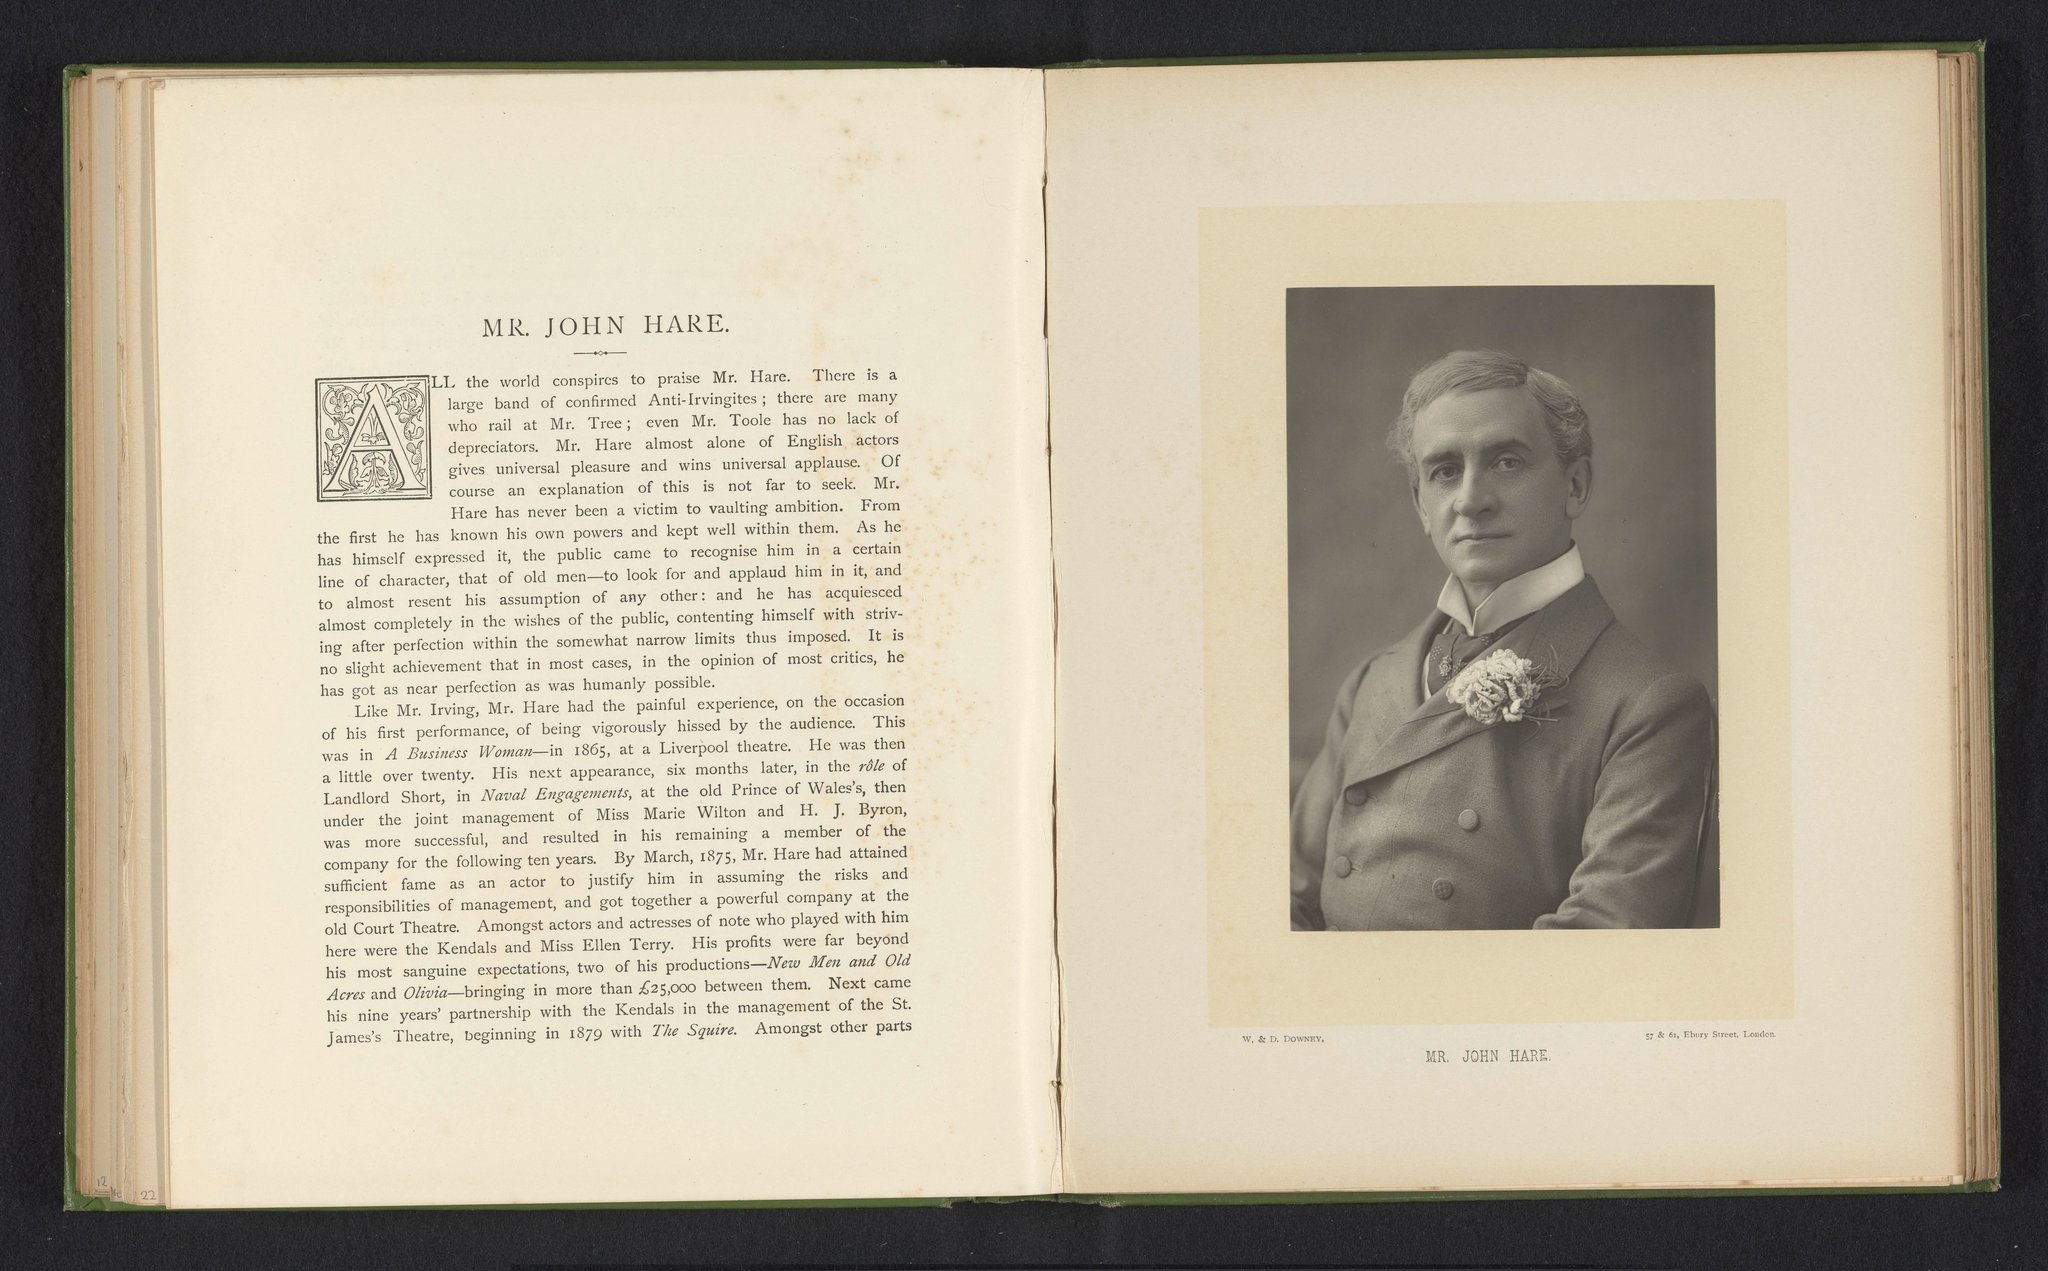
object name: page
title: Portret van John Hare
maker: Anonymous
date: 1884-1894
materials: paper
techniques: woodburytype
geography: london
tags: portrait of actor, actress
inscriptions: inscription: ‘57 & 61, Elbury Street, London.’